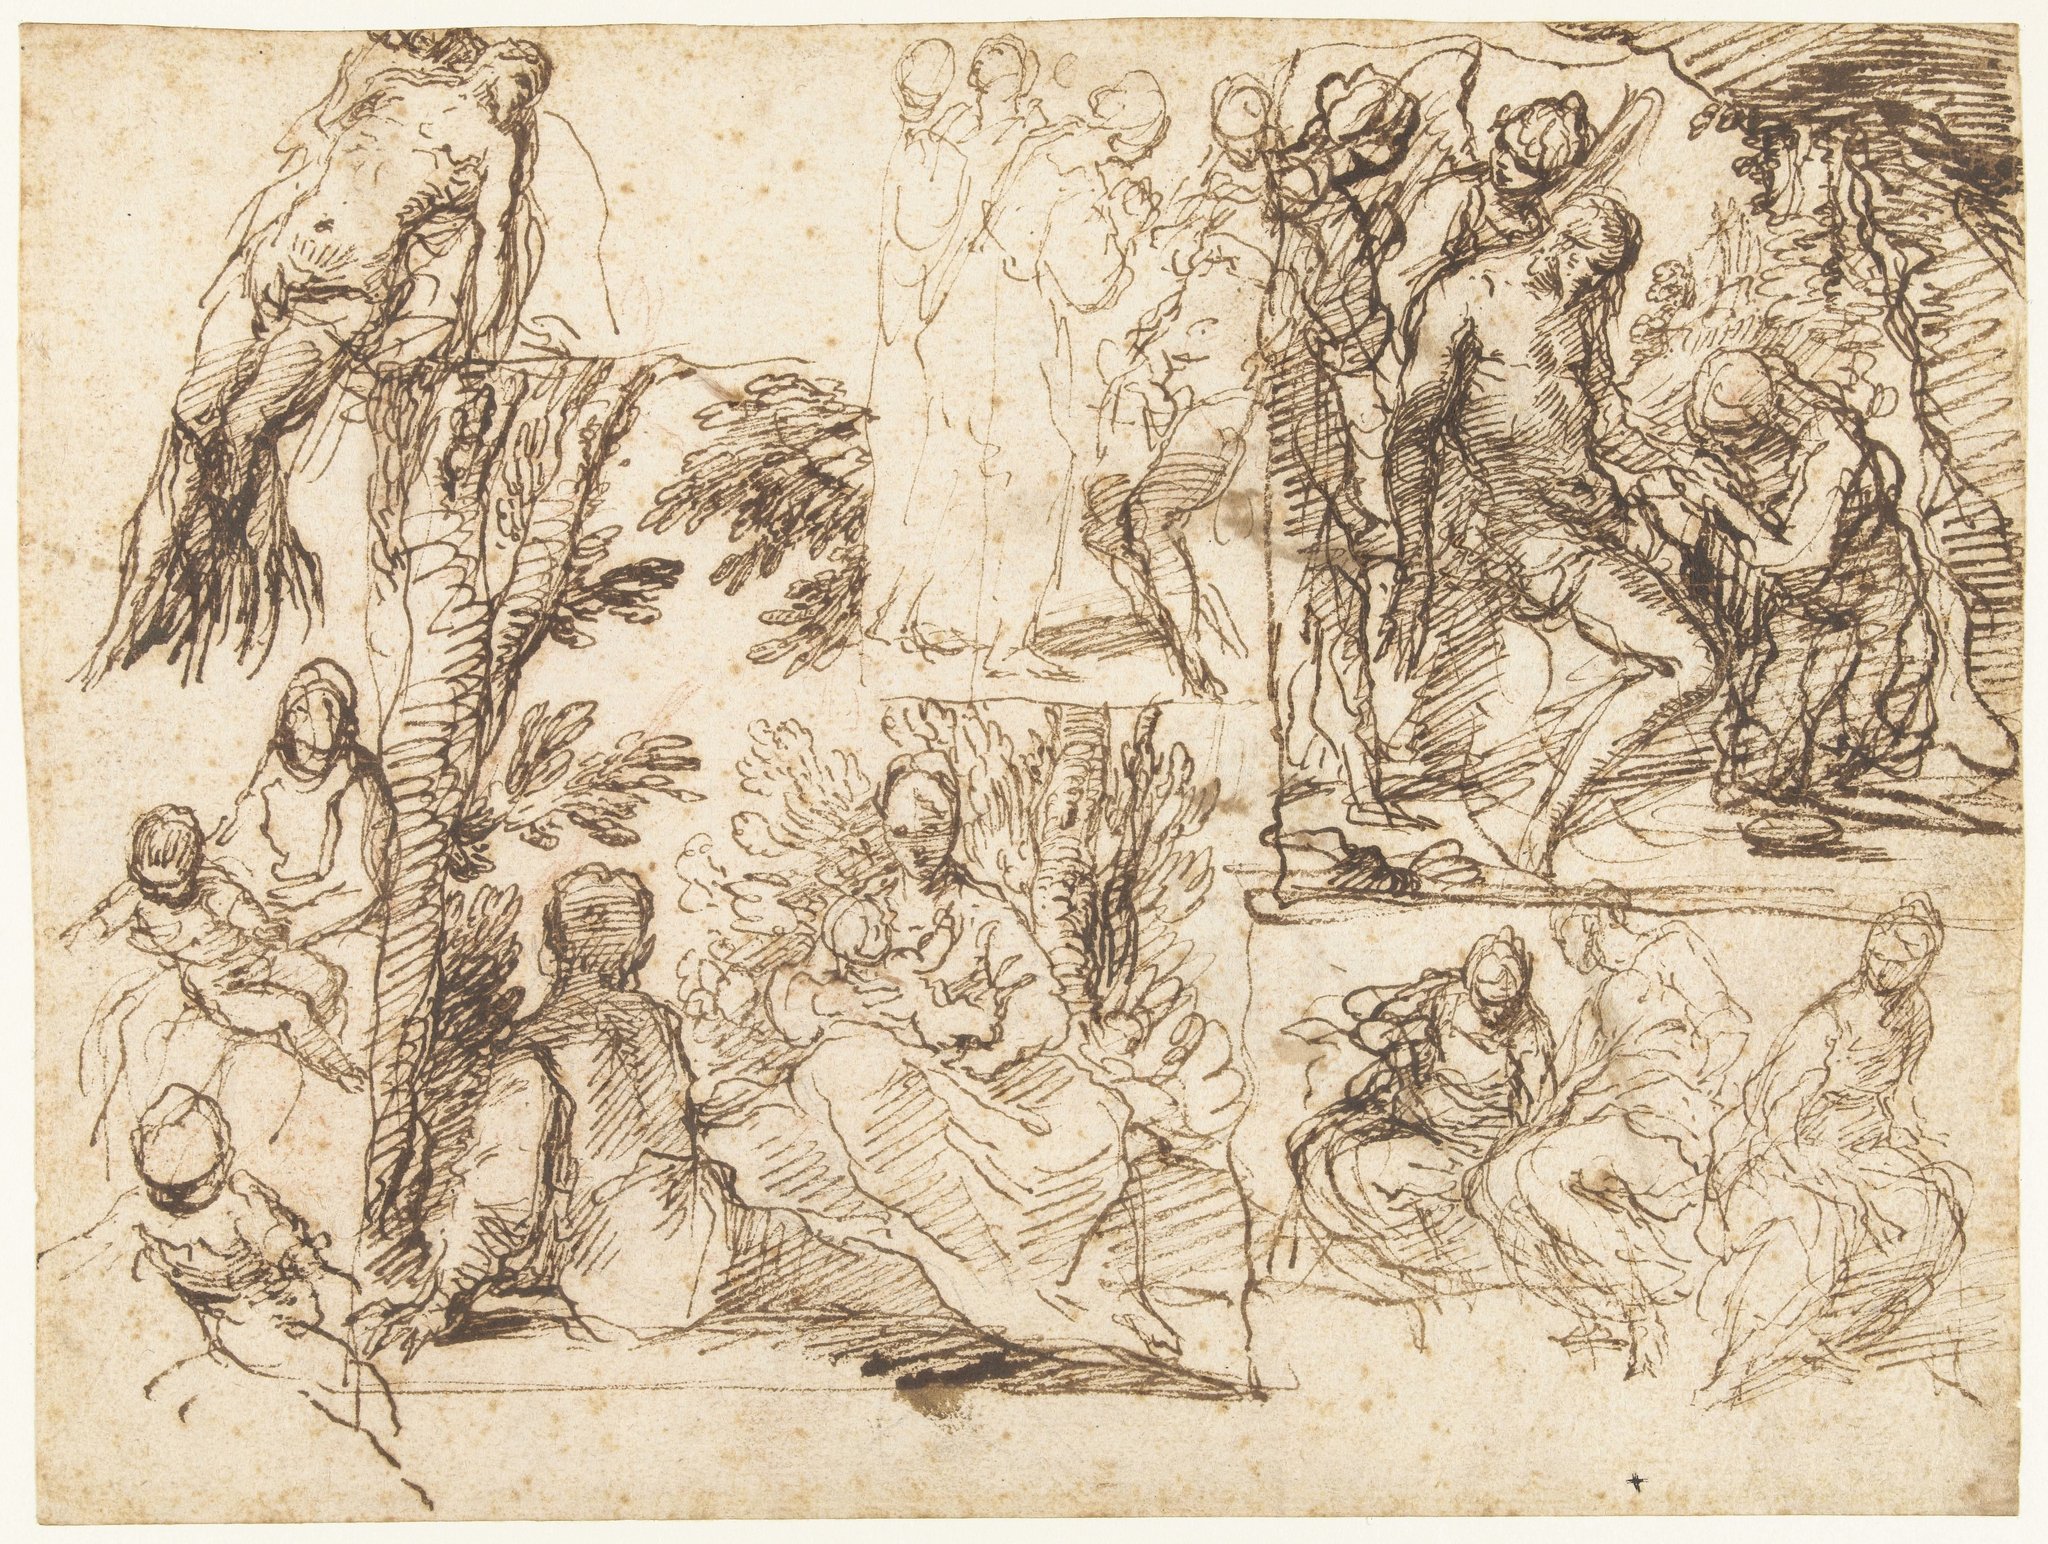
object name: drawing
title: Schetsblad met verschillende composities, waaronder een Bewening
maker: simone cantarini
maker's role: draughtsman, print maker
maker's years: 1612-1648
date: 1635-1645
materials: ink, paper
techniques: pen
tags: rest on the flight into egypt, lamentation over the dead christ by his relatives and friends (christ usually without crown of thorns)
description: Verschillende composities, onder andere een Rust op de vlucht naar Egypte en een Bewening.